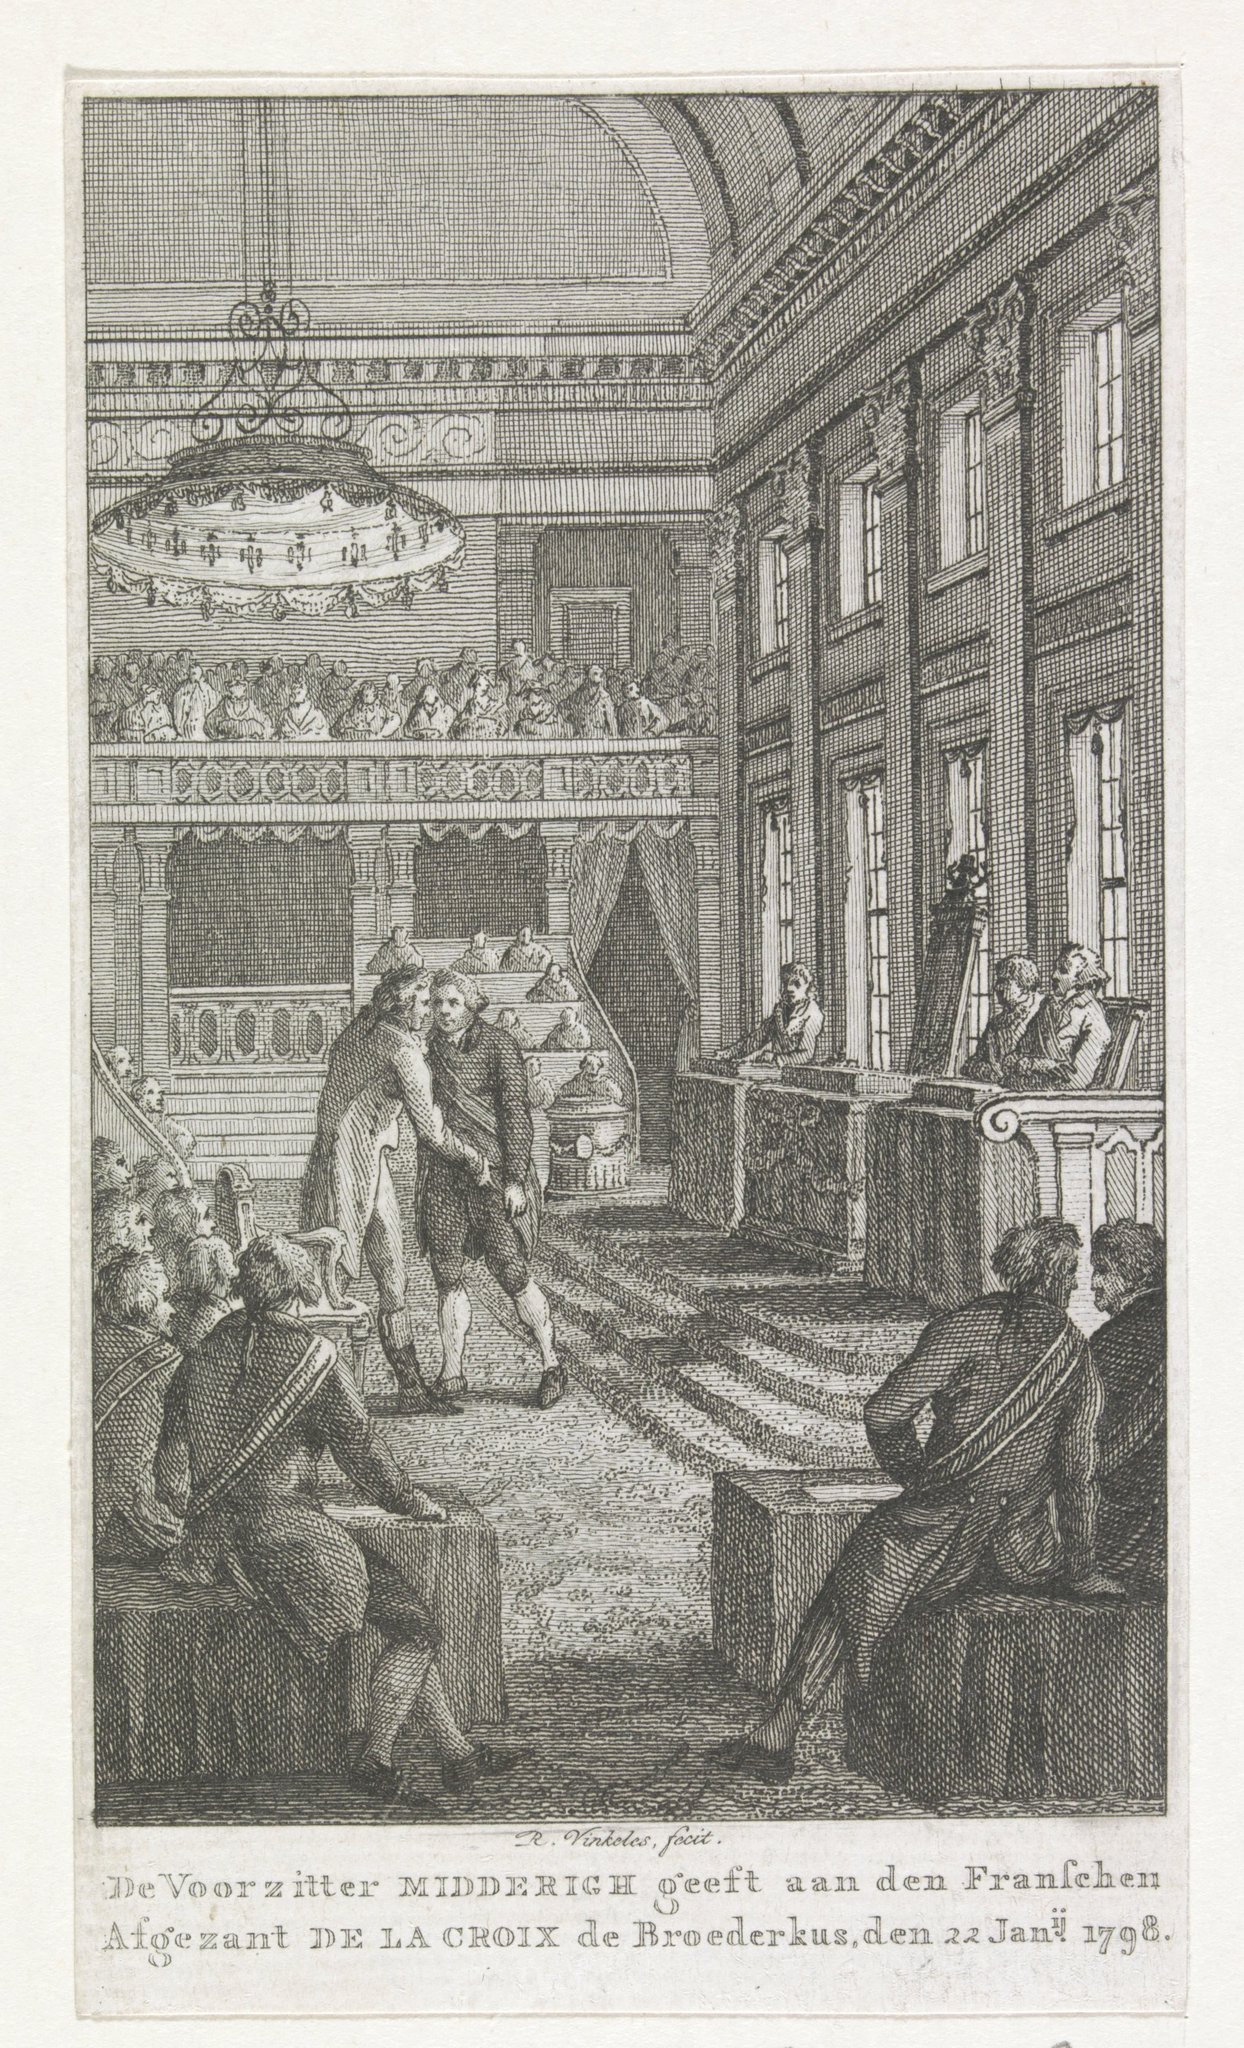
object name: history print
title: De Voorzitter Midderigh geeft aan den Franschen Afgezant De La Croix de Broederkus, den 21 Jan.ij 1798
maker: reinier vinkeles (i)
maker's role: draughtsman, print maker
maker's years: 1741-1816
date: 1805-1807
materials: paper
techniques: engraving, etching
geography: netherlands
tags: politician, embracing each other, kissing, lower house, parliament, chamber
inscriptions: collector's mark: Lugt 2228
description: Gebruikt als illustratie in: P.A. Loosjes. Vaderlandsche historie, vervattende de geschiedenissen, der Vereenigde Nederlanden (...). Ten onmiddelyken vervolge van Wagenaar's Vaderlandsche historie. Amsterdam: Johannes Allart, dl. 39 (1807).